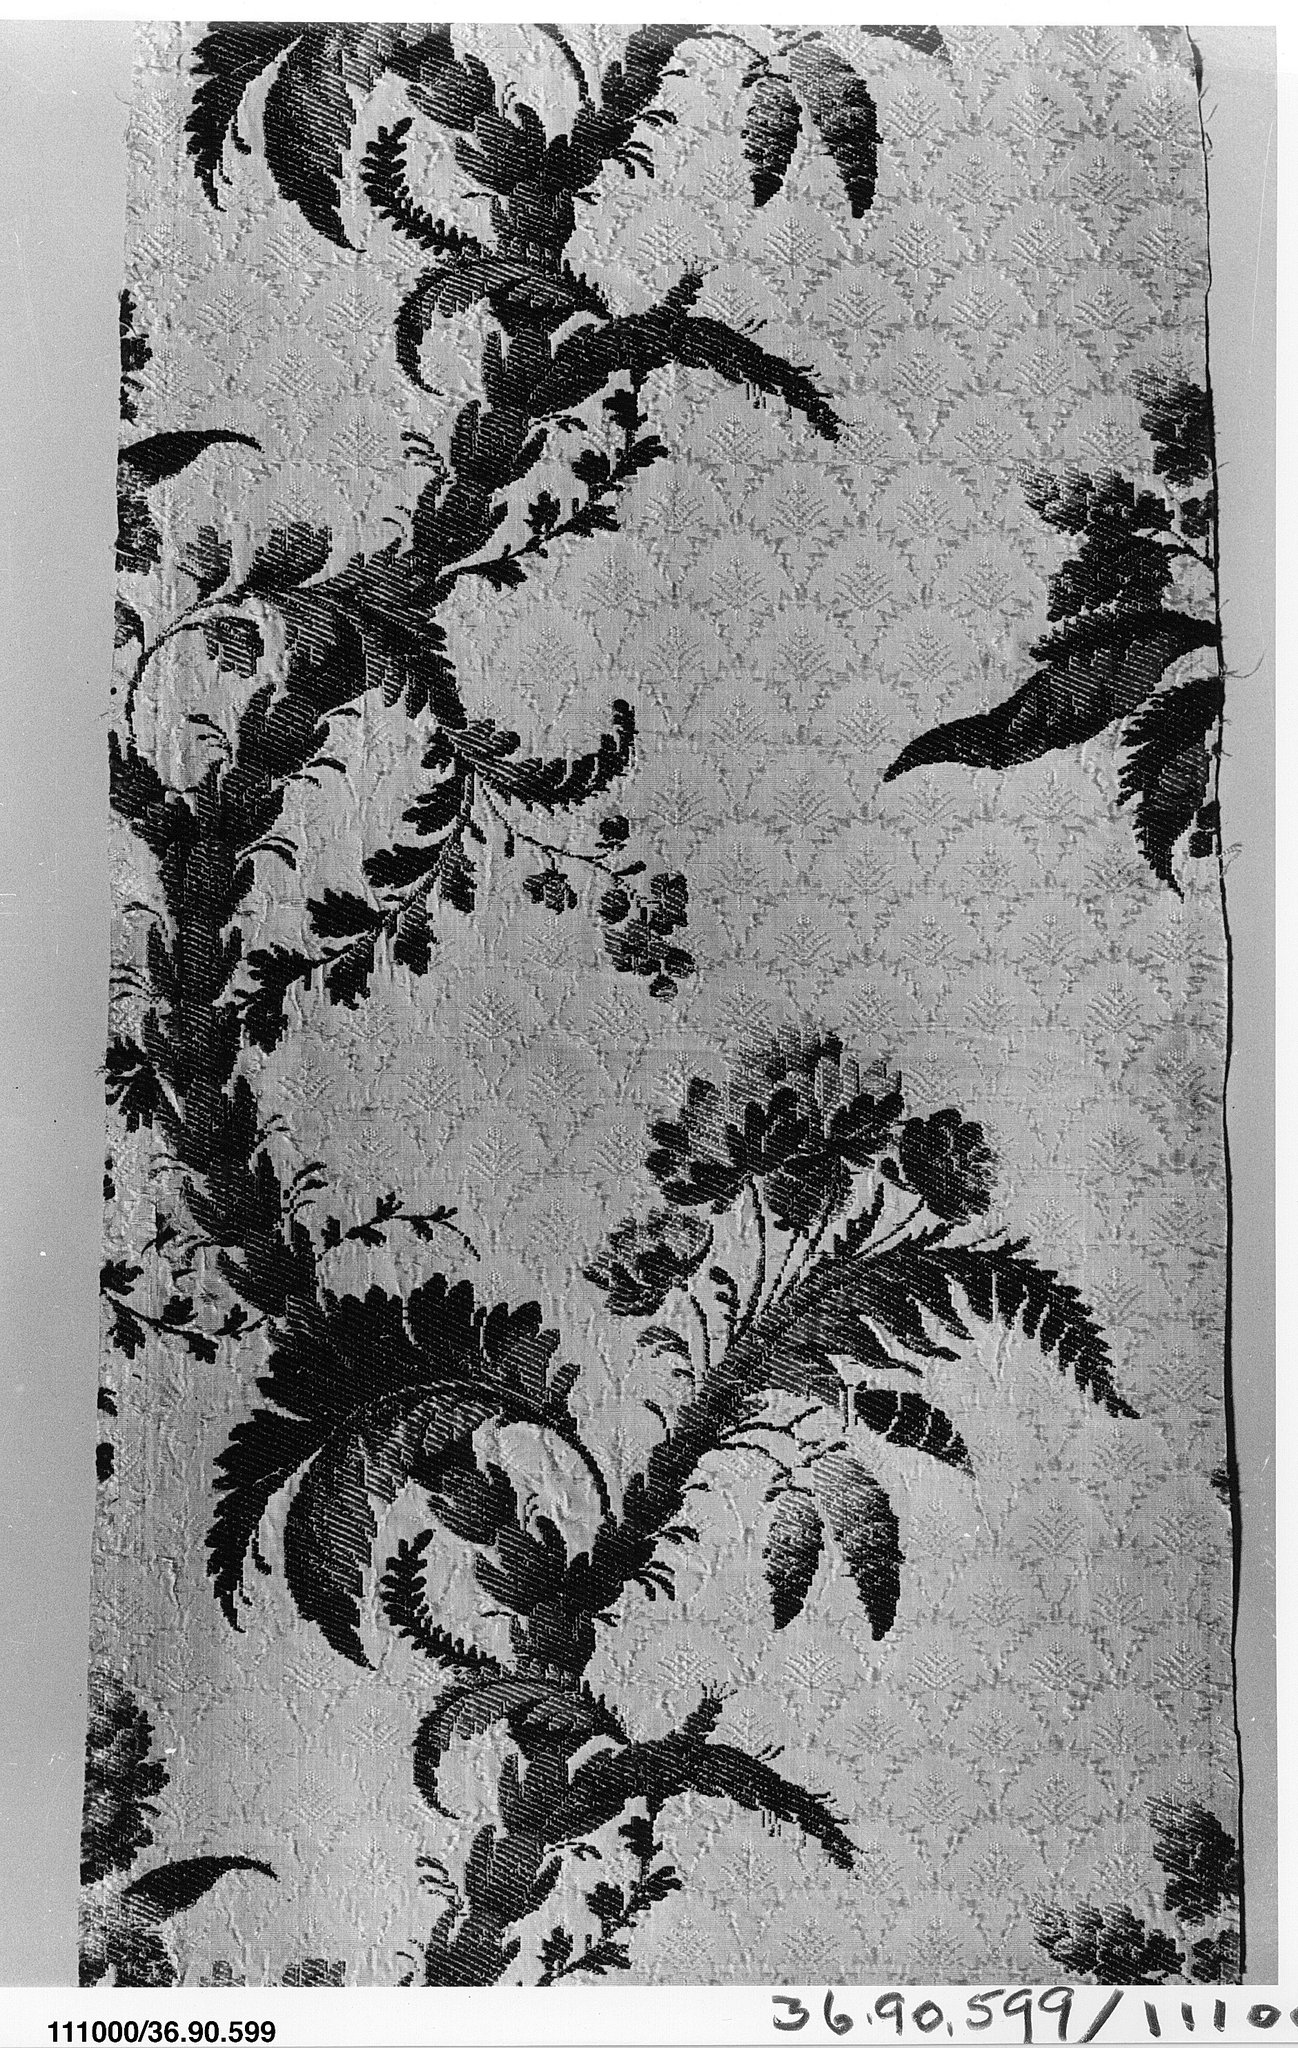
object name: piece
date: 1734-1766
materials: silk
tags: flowers,leaves